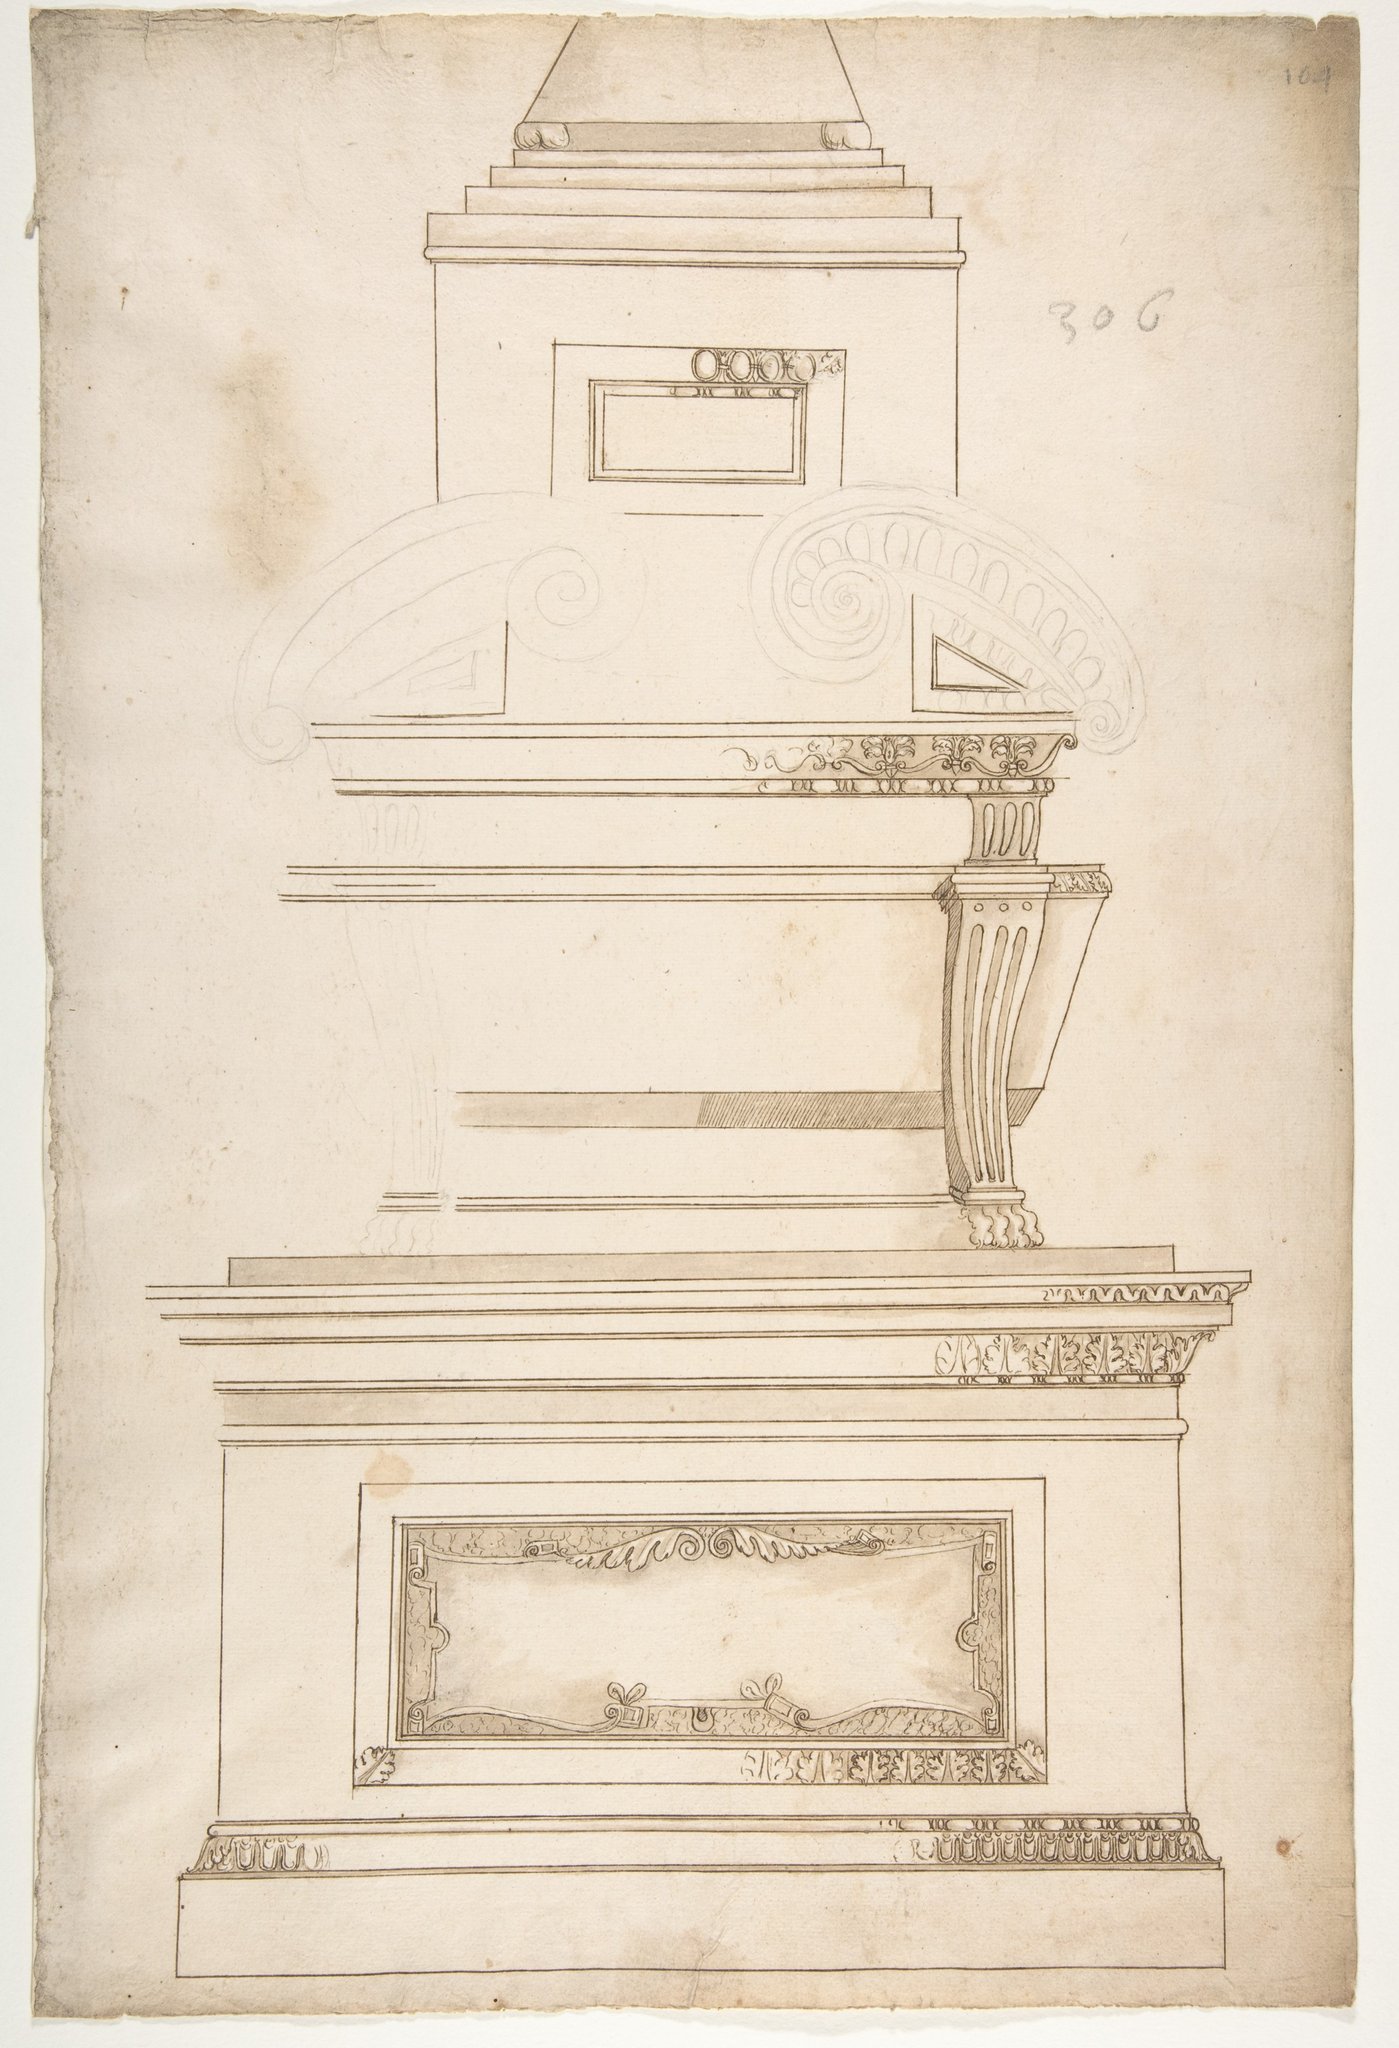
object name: drawing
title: Design for a Sarcophagus on a Pedestal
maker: anonymous, french, 16th century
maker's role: artist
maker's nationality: french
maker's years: 1500-1600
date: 1501-1600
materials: chalk, ink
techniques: brush, pen, wash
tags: architecture,sarcophagus